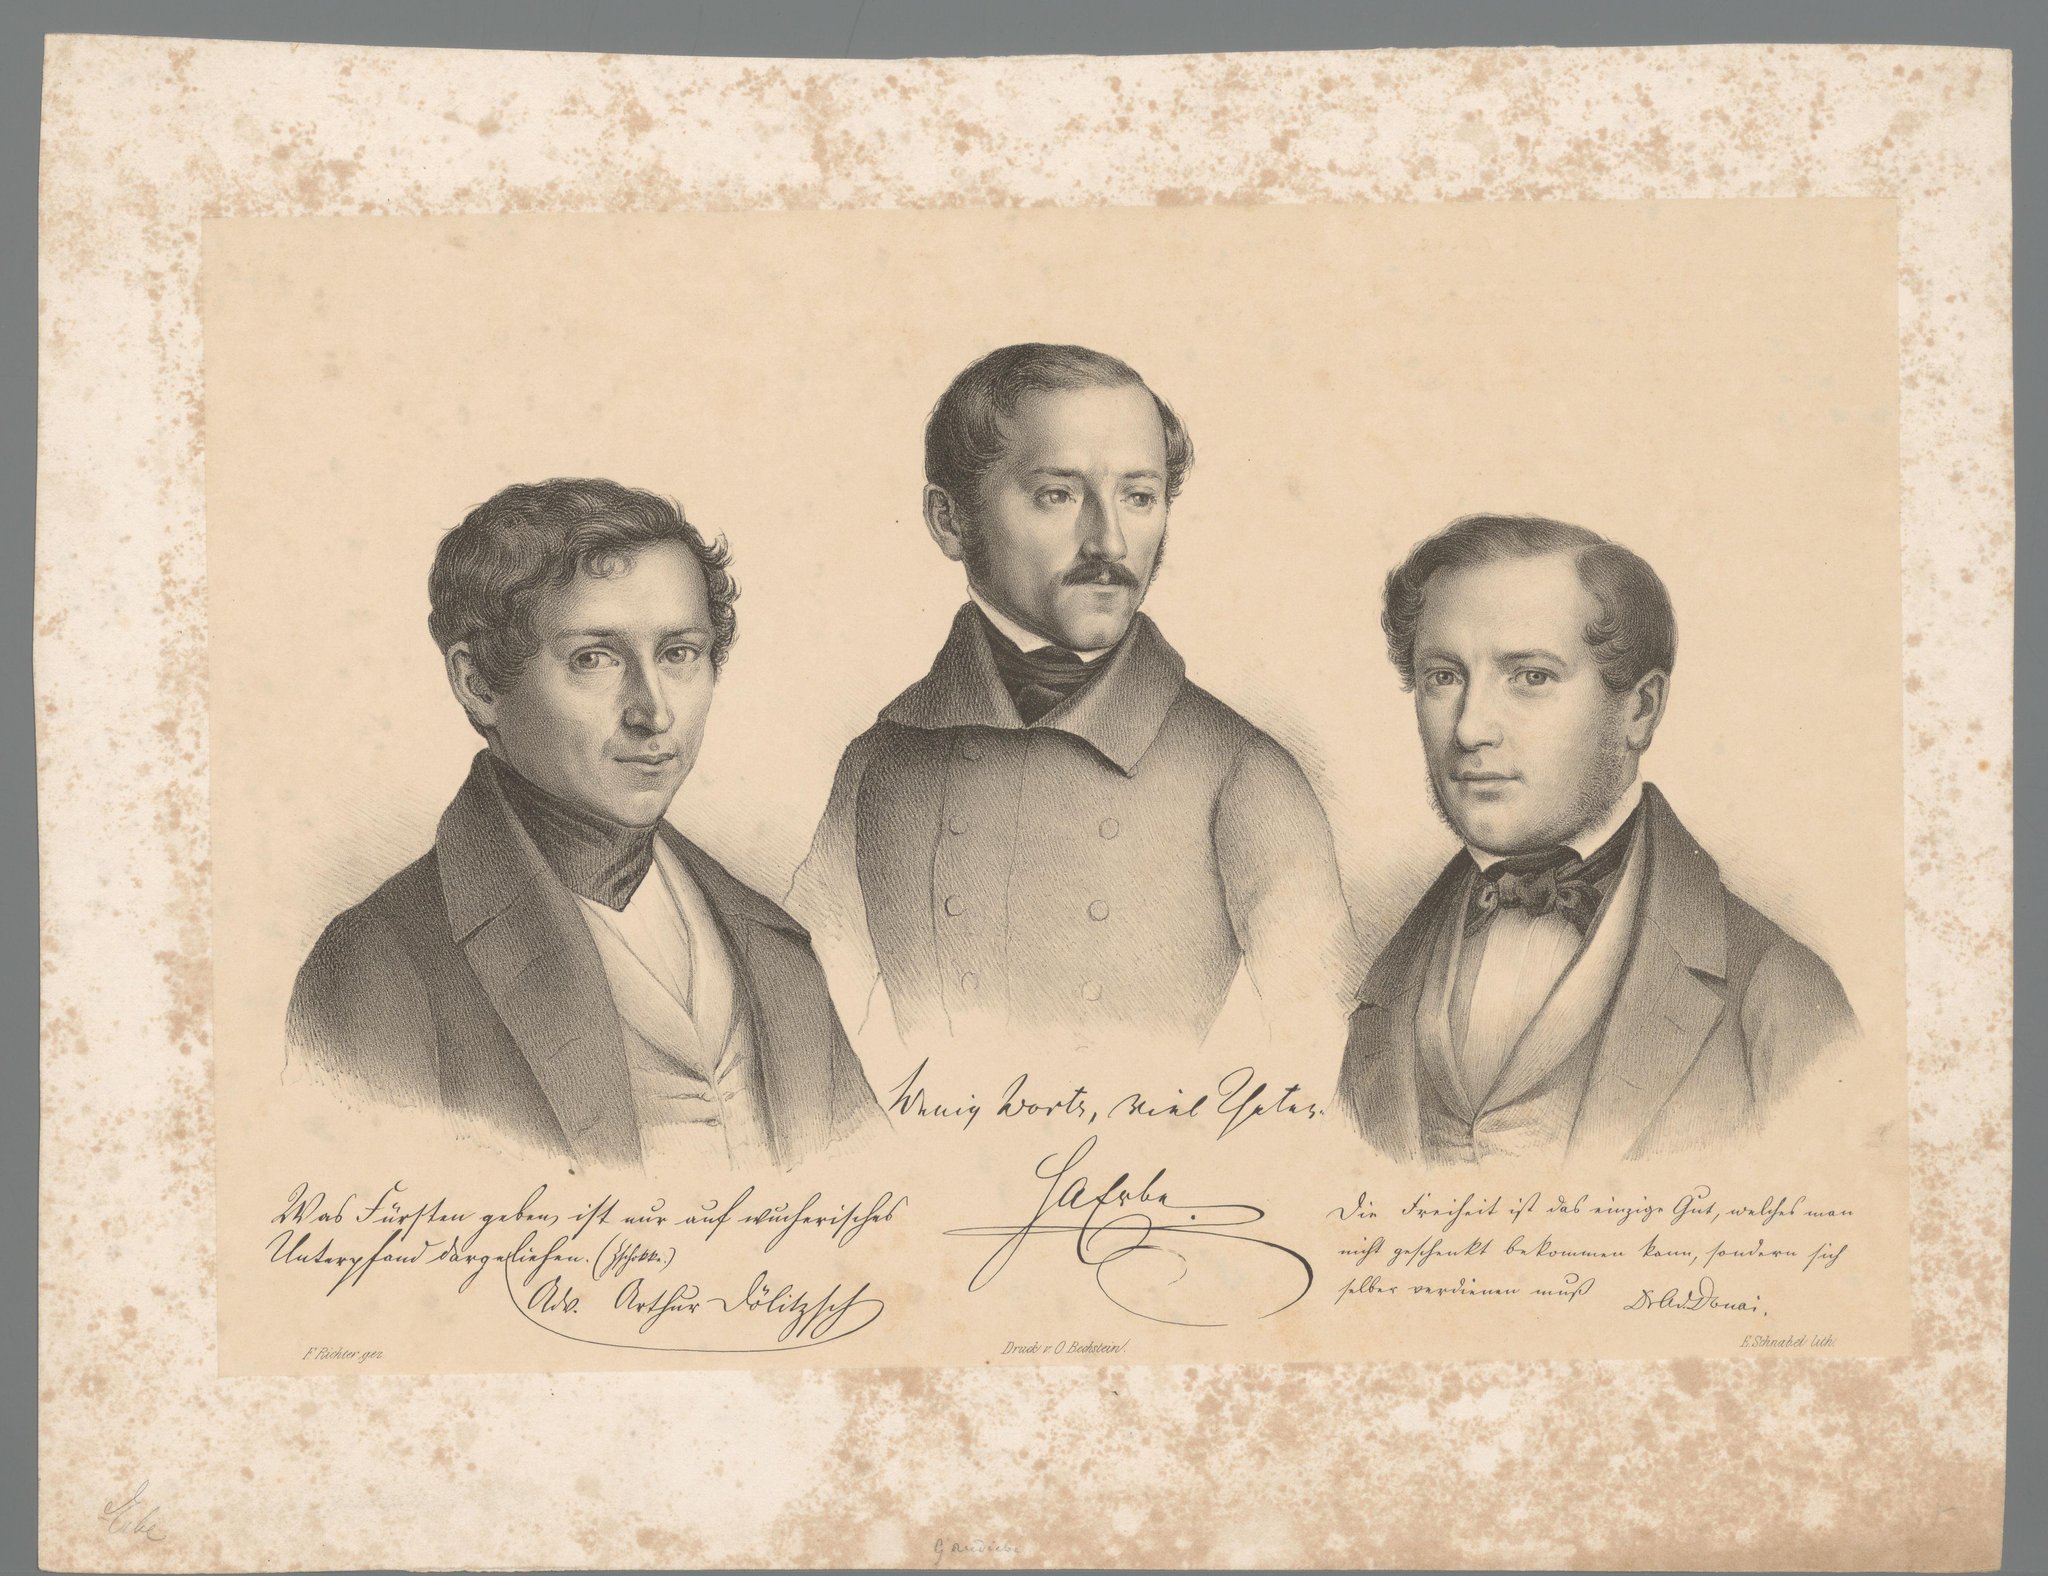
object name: print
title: Portret van Hans Alfred Erbe, Arthur Ottomar Olympius Dölitzsch en A. Donai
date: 1830-1880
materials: paper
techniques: lithograph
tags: new york (city), politician, historical persons, law and jurisprudence, historical persons not known by name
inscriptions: collector's mark: Lugt 2228